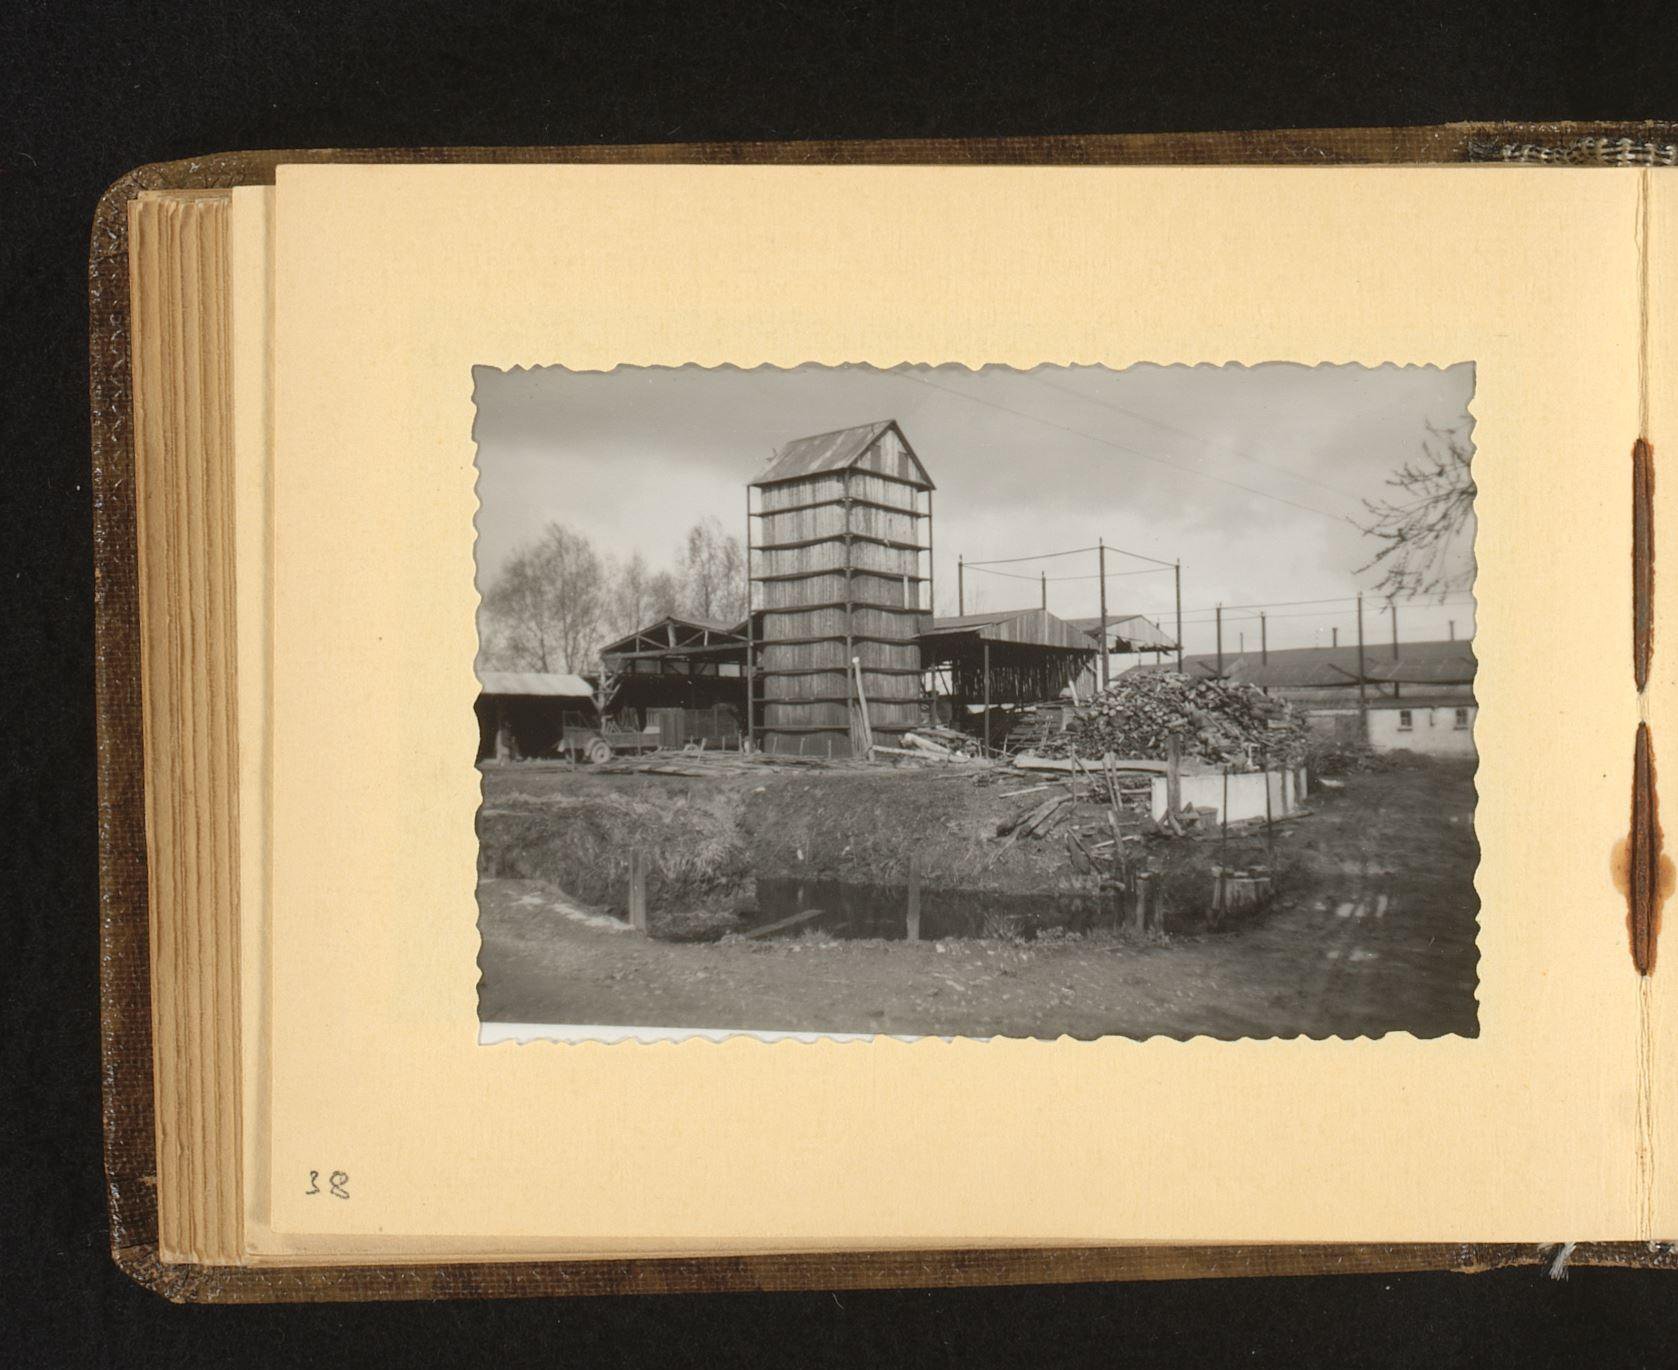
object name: album leaf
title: Silo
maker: Anonymous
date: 1904-1939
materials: cardboard, photographic support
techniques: gelatin silver print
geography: gelderland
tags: large-scale structure for storage, e.g.: warehouse, depot, silo, open-air recreation, gelderland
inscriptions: inscription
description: Albumblad met een foto van een boerderij met een silo, op Ruimzicht. Onderdeel van het familiealbum 1938-1939.